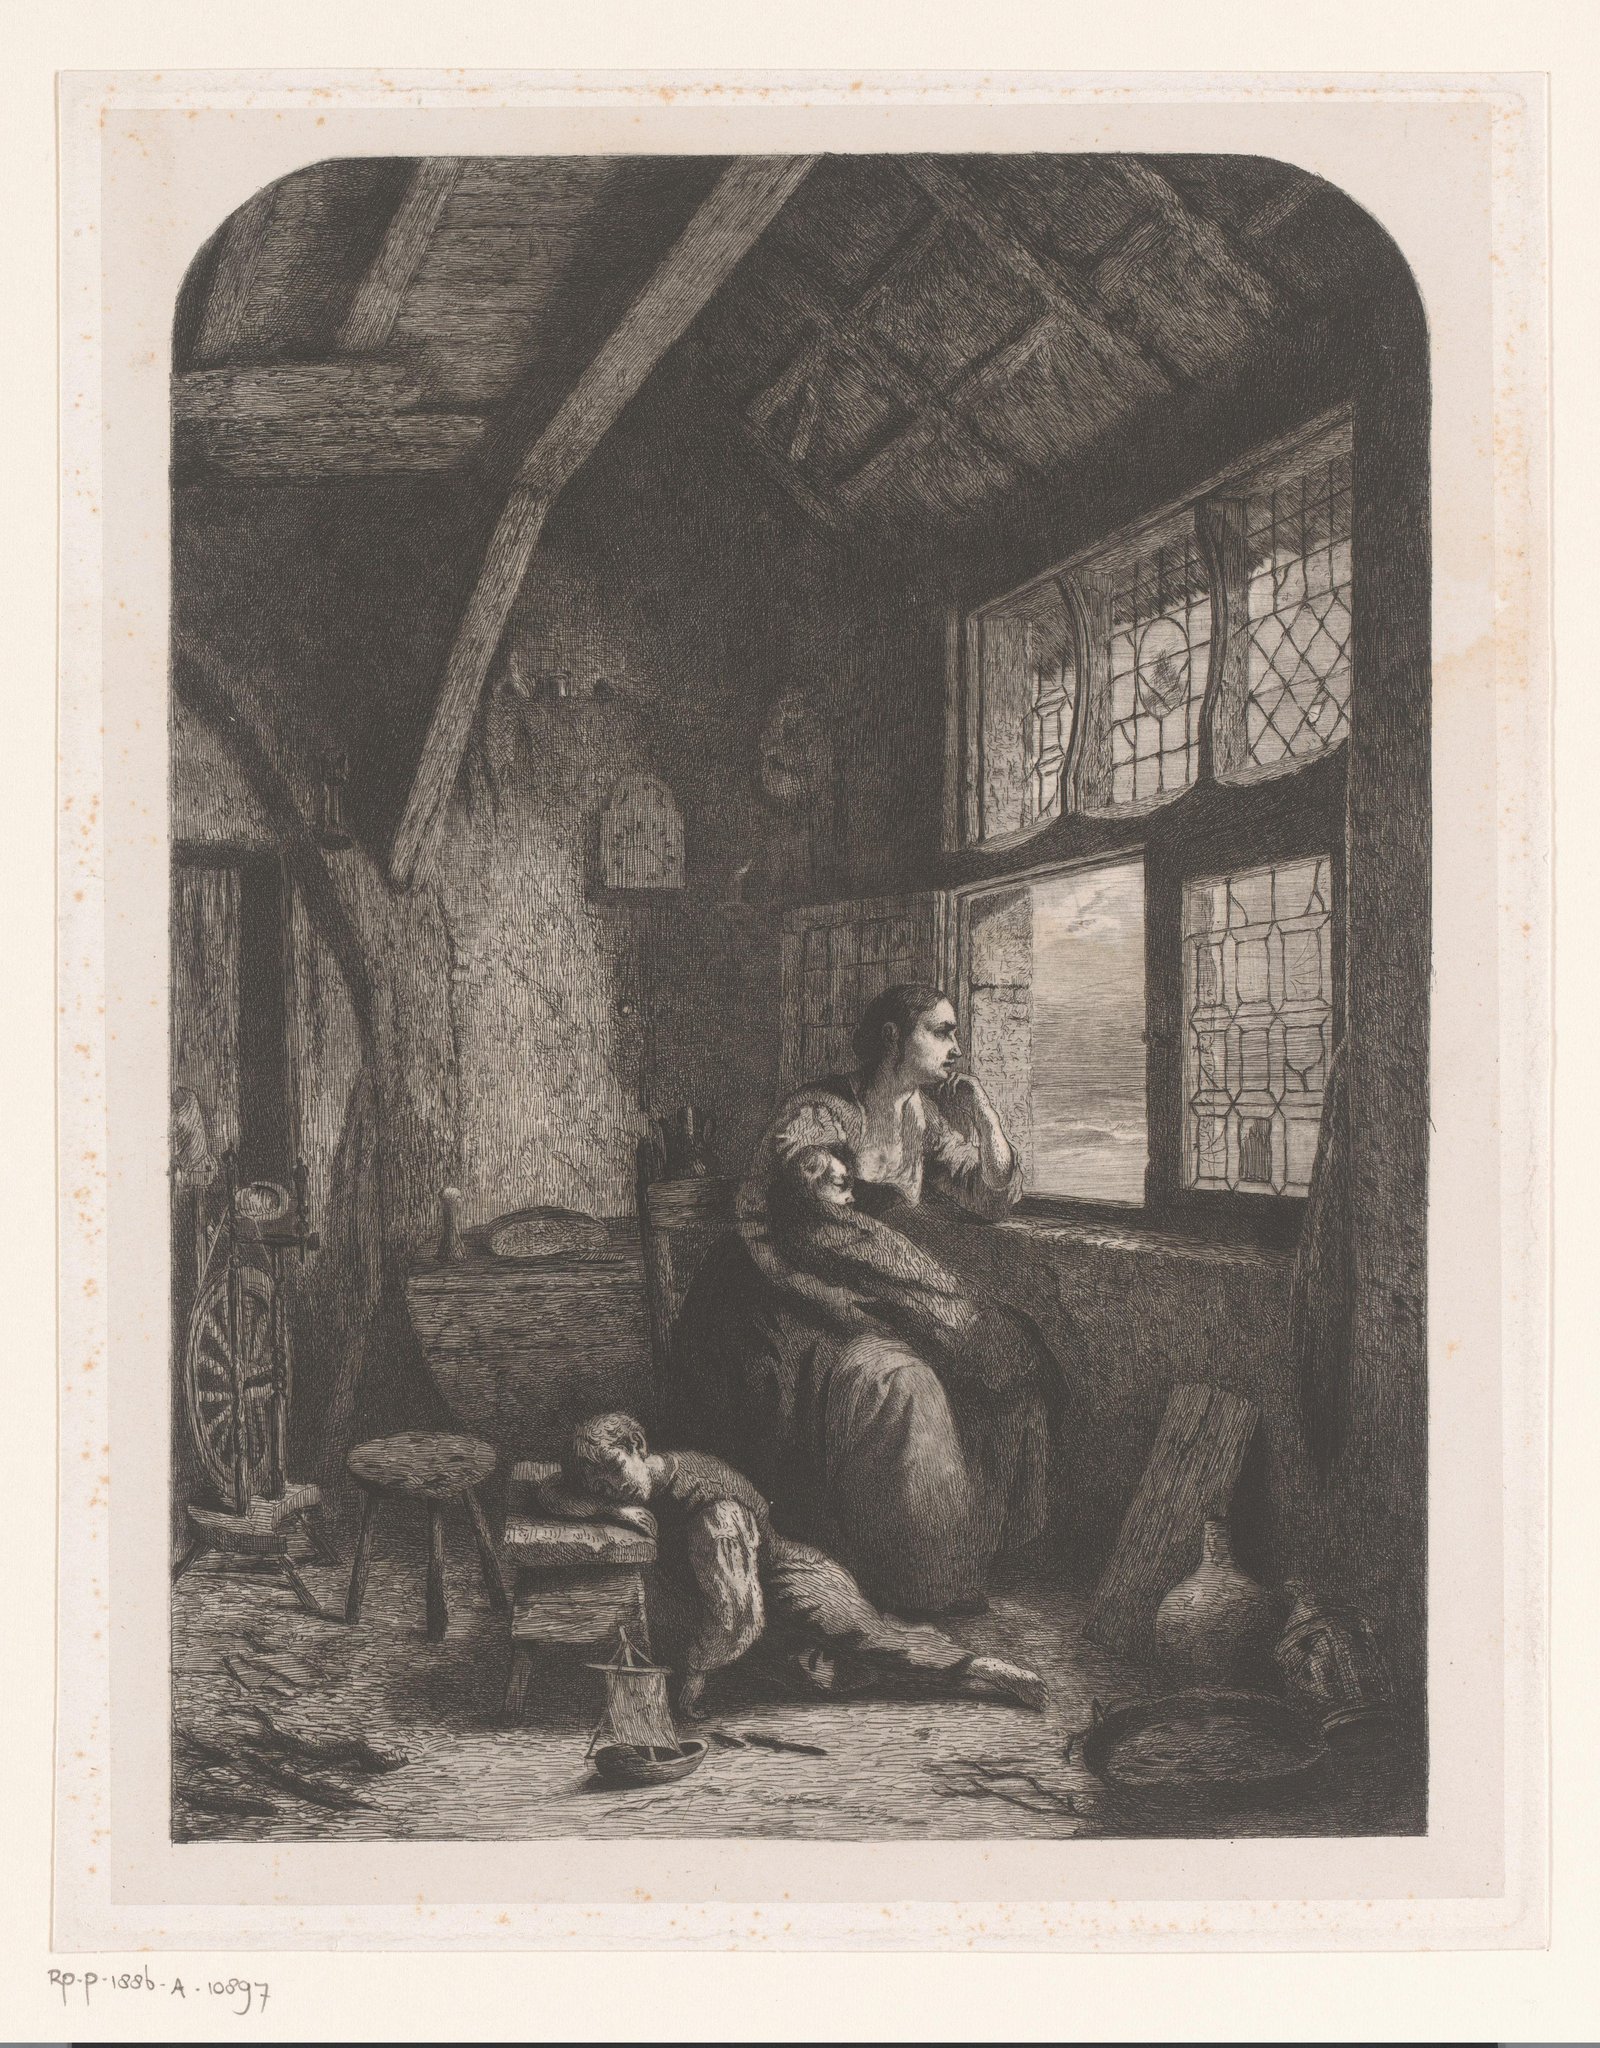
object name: print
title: Vrouw met twee slapende kinderen wachtend bij een open raam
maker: willem linnig (i)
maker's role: print maker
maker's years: 1819-1885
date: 1856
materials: paper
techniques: etching, intaglio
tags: mother and child(ren), woman and child(ren) (family group)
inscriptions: collector's mark: Lugt 2228